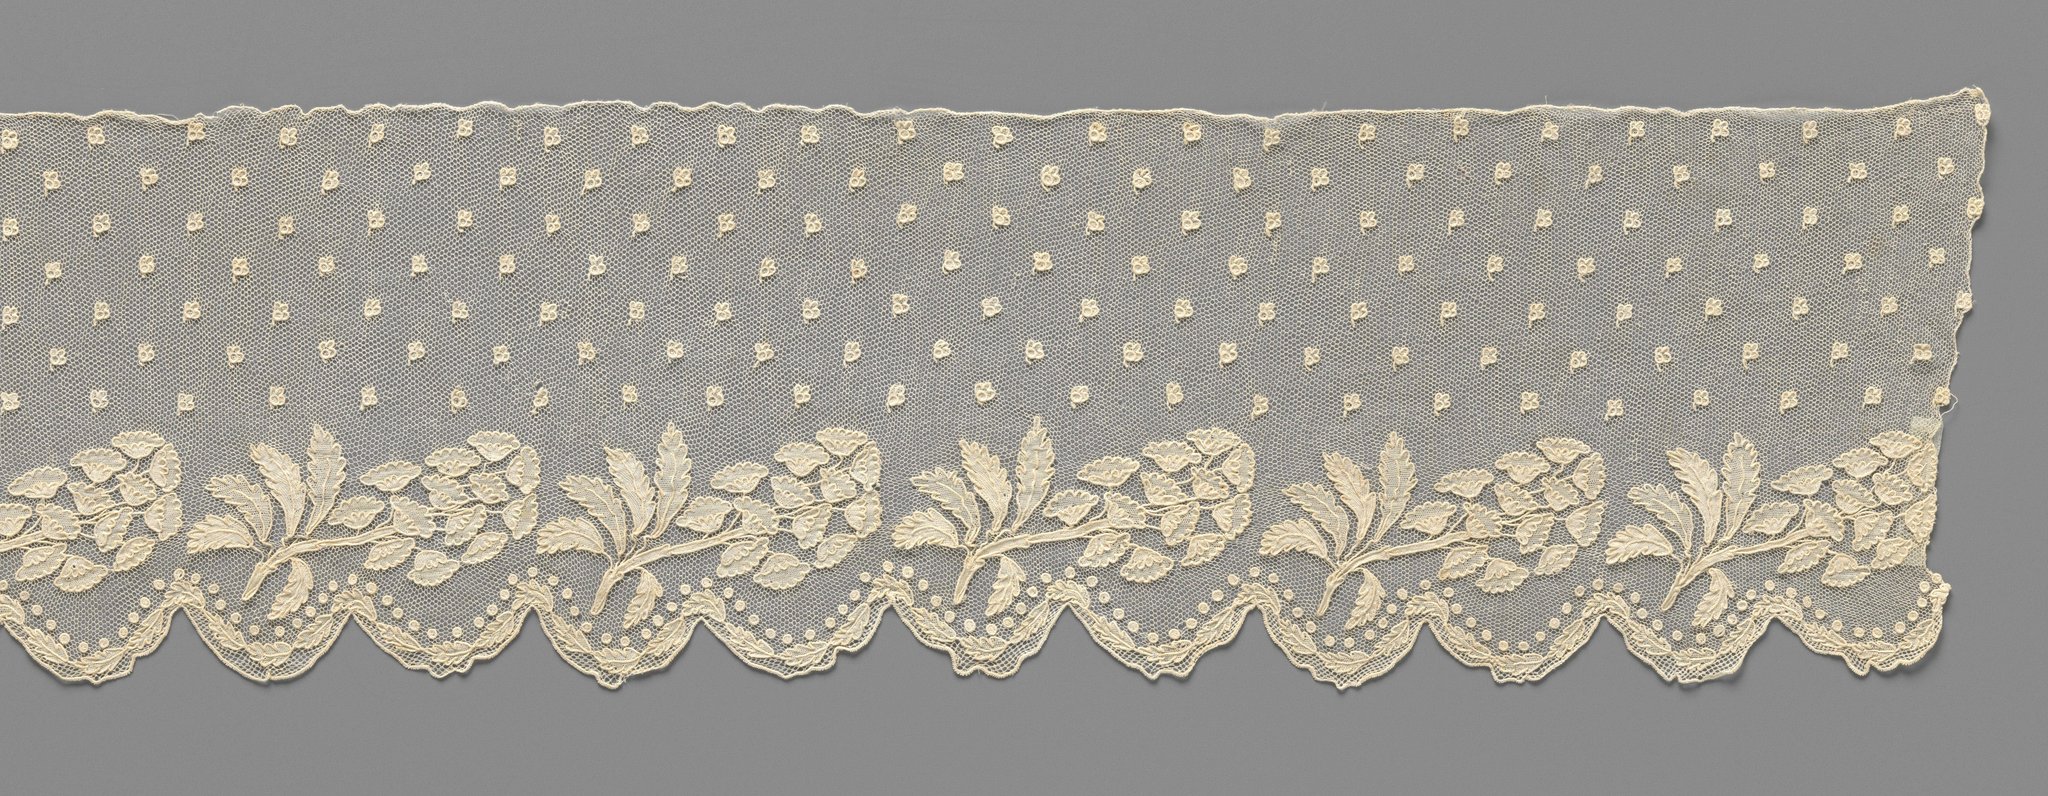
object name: strip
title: Strook naaldkant met schuinliggende trosbloem boven twee schulpen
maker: Anonymous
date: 1900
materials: linen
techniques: lace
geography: burano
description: Strook naturelkleurige naaldkant: Alençon-kant. Het zich herhalende patroon bestaat langs de schulpenrand uit een schuin liggende tak met een trosbloem met waaiervormige bloempjes. Onder de bloem zitten vijf veervormige bladeren aan de tak, waarvan er vier omhoog gericht zijn en één blad hangt naar beneden. Boven de bloemtakken staat een strooipatroon van ronde bloempjes met drie bloemblaadjes. Onder elke bloemtak zitten twee halfronde schulpen. Langs de schulpen loopt een rand van aaneengeschakelde veervormigeblaadjes met daarboven een meegolvende stippellijn van moesjes en daaronder een smal siergrondje. De motieven zijn met elkaar verbonden door een Alençon-grond. De schulpen zijn afgewerkt met een uiterst fijn picotrandje. De bovenzijde van de strook is recht afgewerkt.